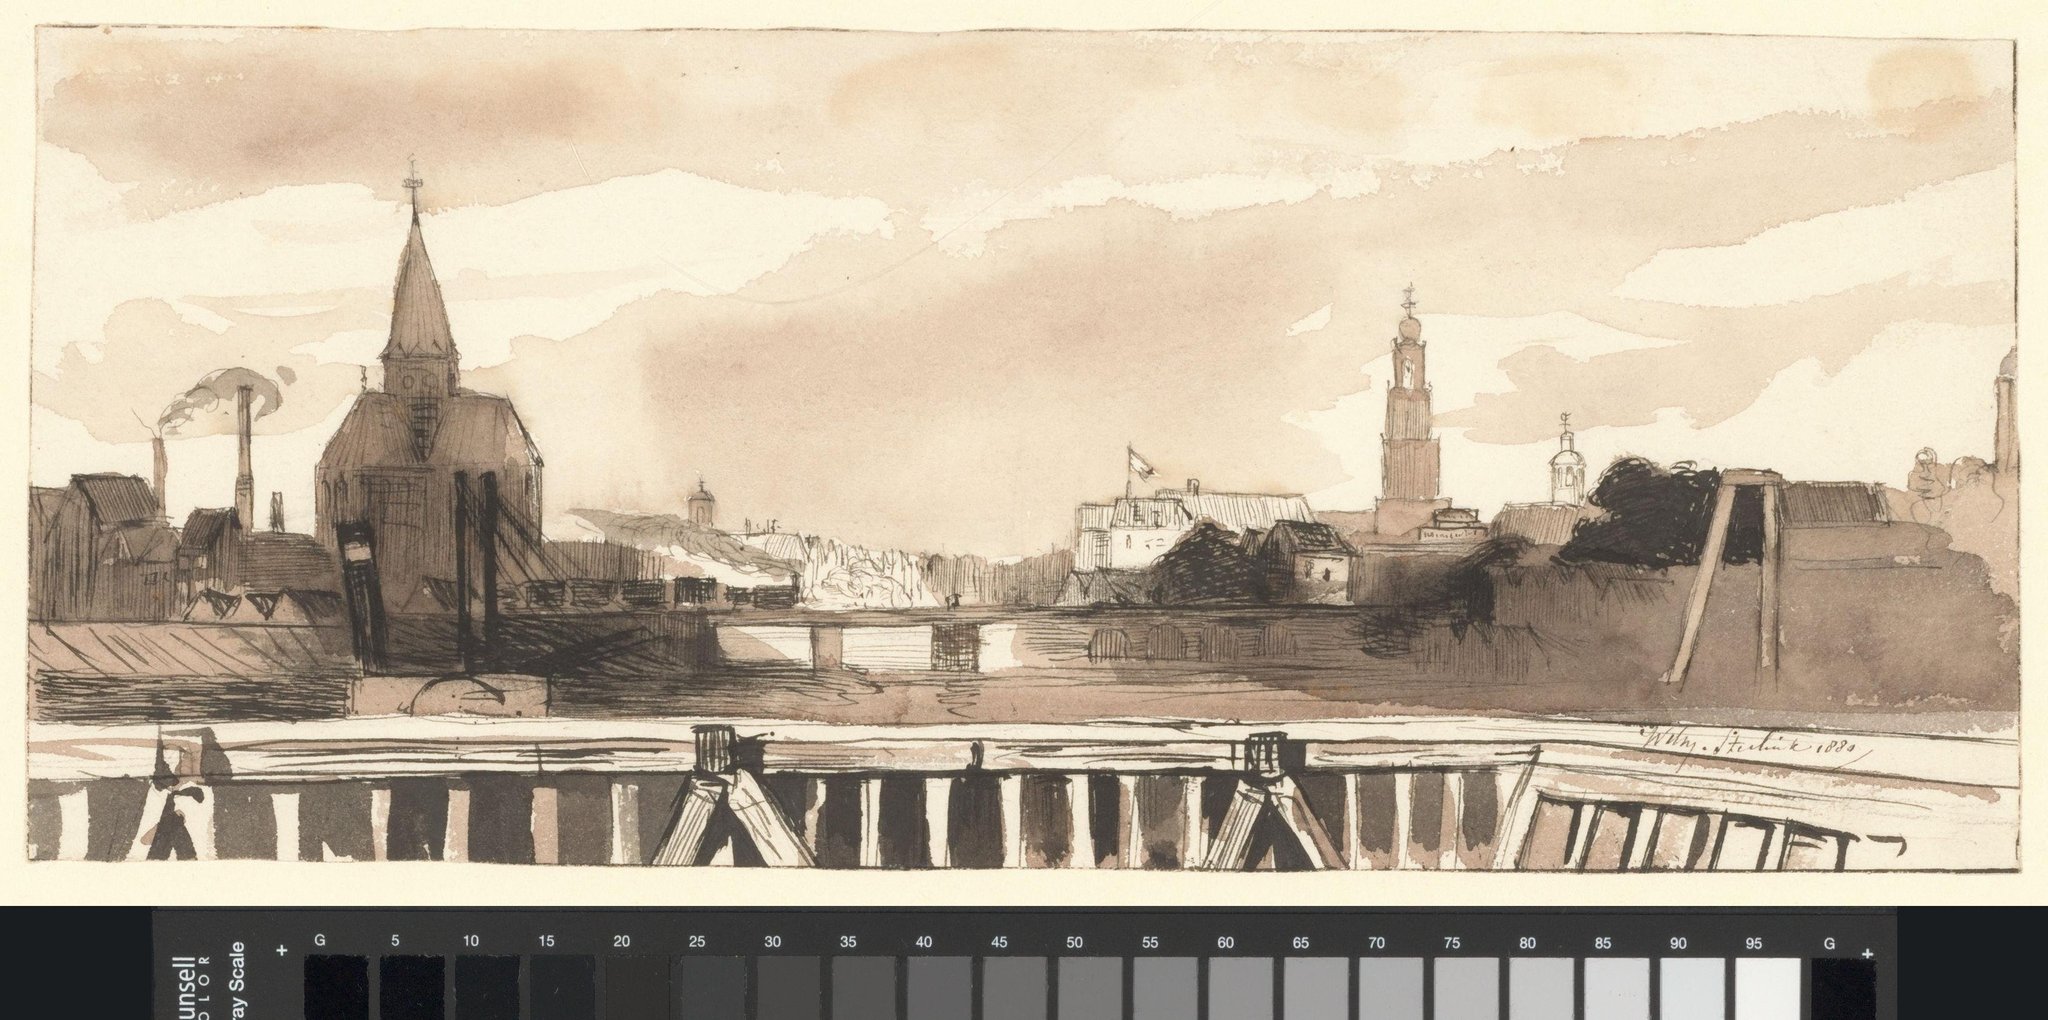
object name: drawing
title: Gezicht vanaf de Westerdoksdijk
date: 1866-1913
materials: ink, paper, pencil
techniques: brush, pen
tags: tower, clock tower ~ monumental adornment, city-view in general; 'veduta', dikes, levee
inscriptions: inscription: ‘Port. 2’, inscription: ‘Westen / noorden / de (...) aan de Westerdoksdyk.’, signature and date: ‘Wilm. Steelink 1880’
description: Onderwerpsrubriek binnen de Atlas Amsterdam: Gezichten van het IJ op het westelijk gedeelte der stad, Blauwhoofd tot Nieuwebrug.